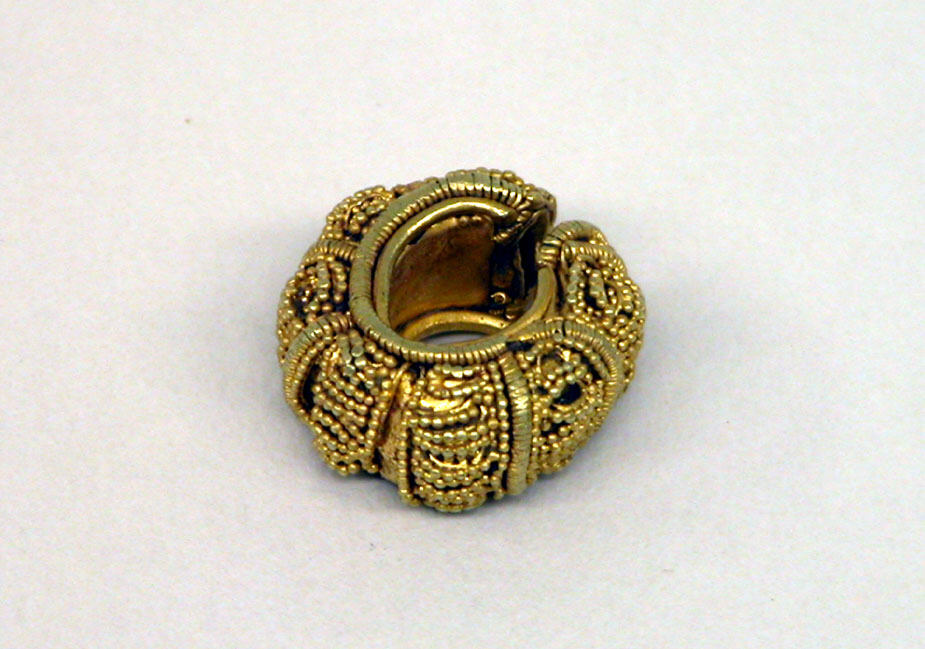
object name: ear ornament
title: Ear Ornament with Granulate Design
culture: indonesian, javanese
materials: gold